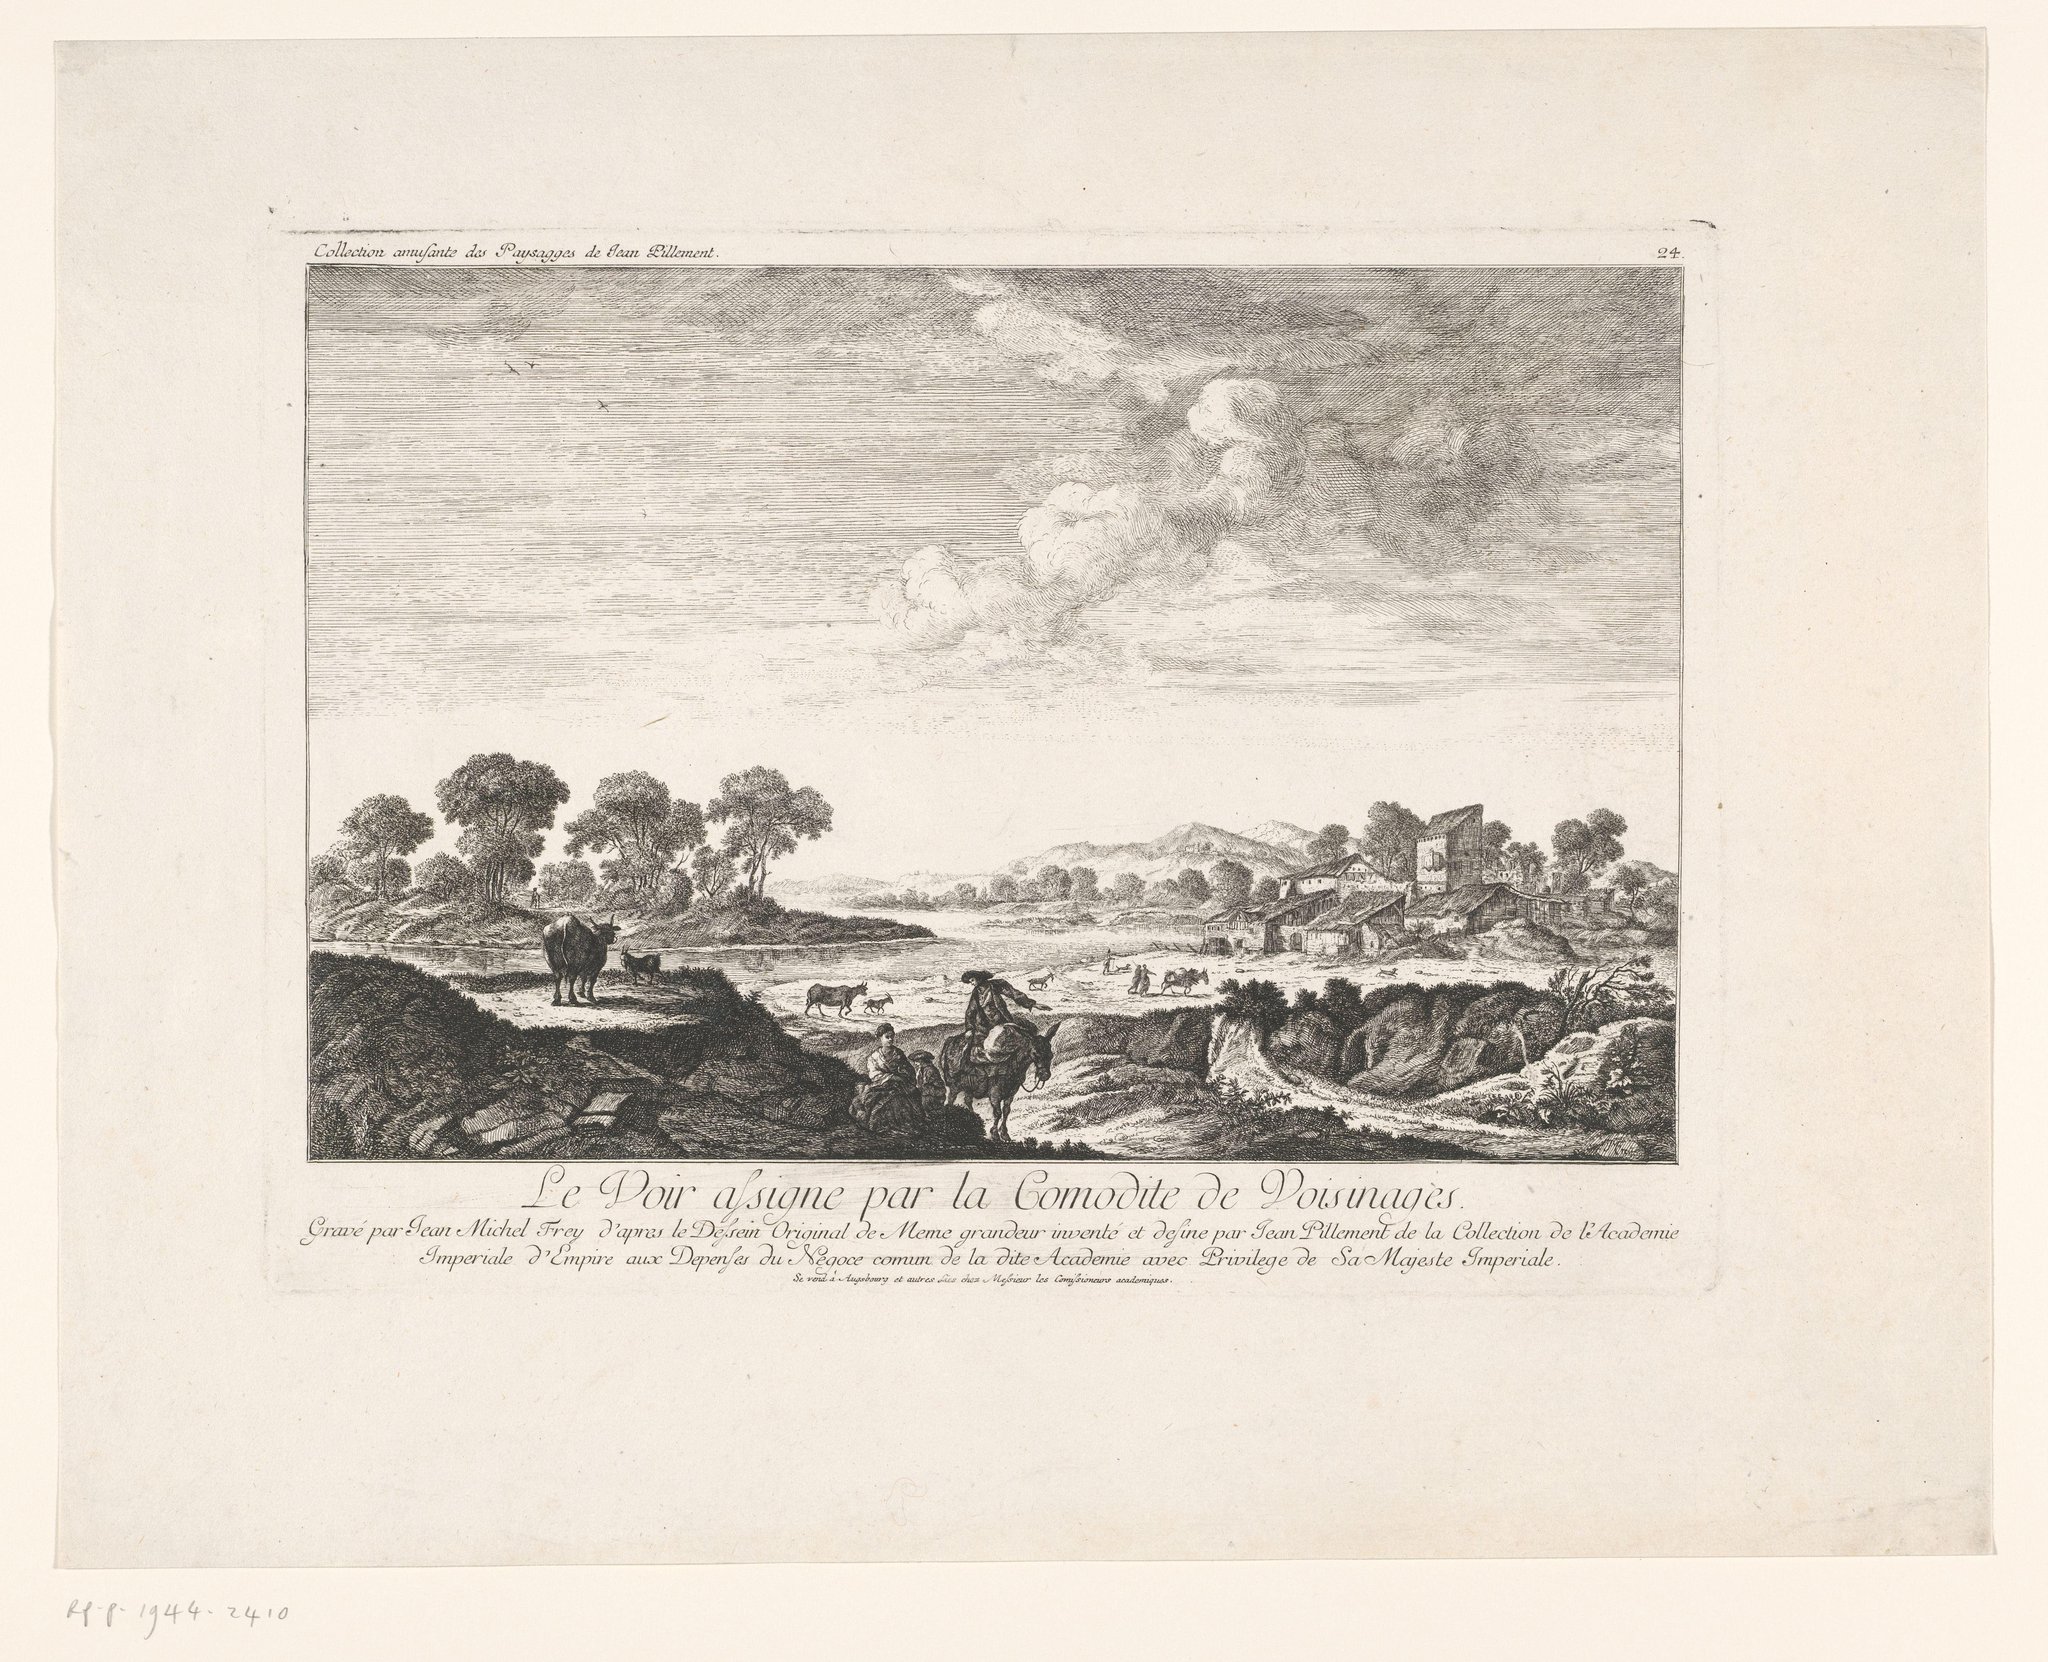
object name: print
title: Rivierlandschap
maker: johann michael frey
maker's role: print maker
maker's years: 1750-1818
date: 1760-1818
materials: paper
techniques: etching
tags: landscapes with waters, waterscapes, seascapes (in the temperate zone)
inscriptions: collector's mark: Lugt 2228